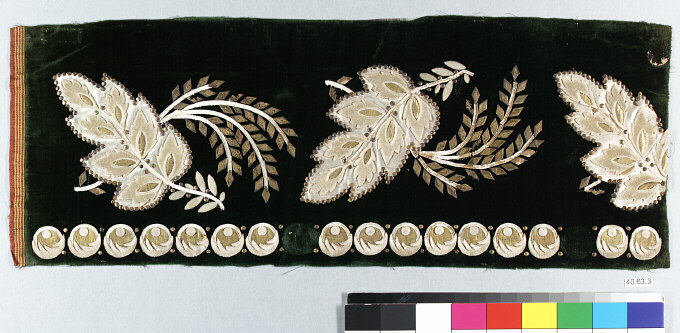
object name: border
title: Dress border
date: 1801-1833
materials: velvet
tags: leaves